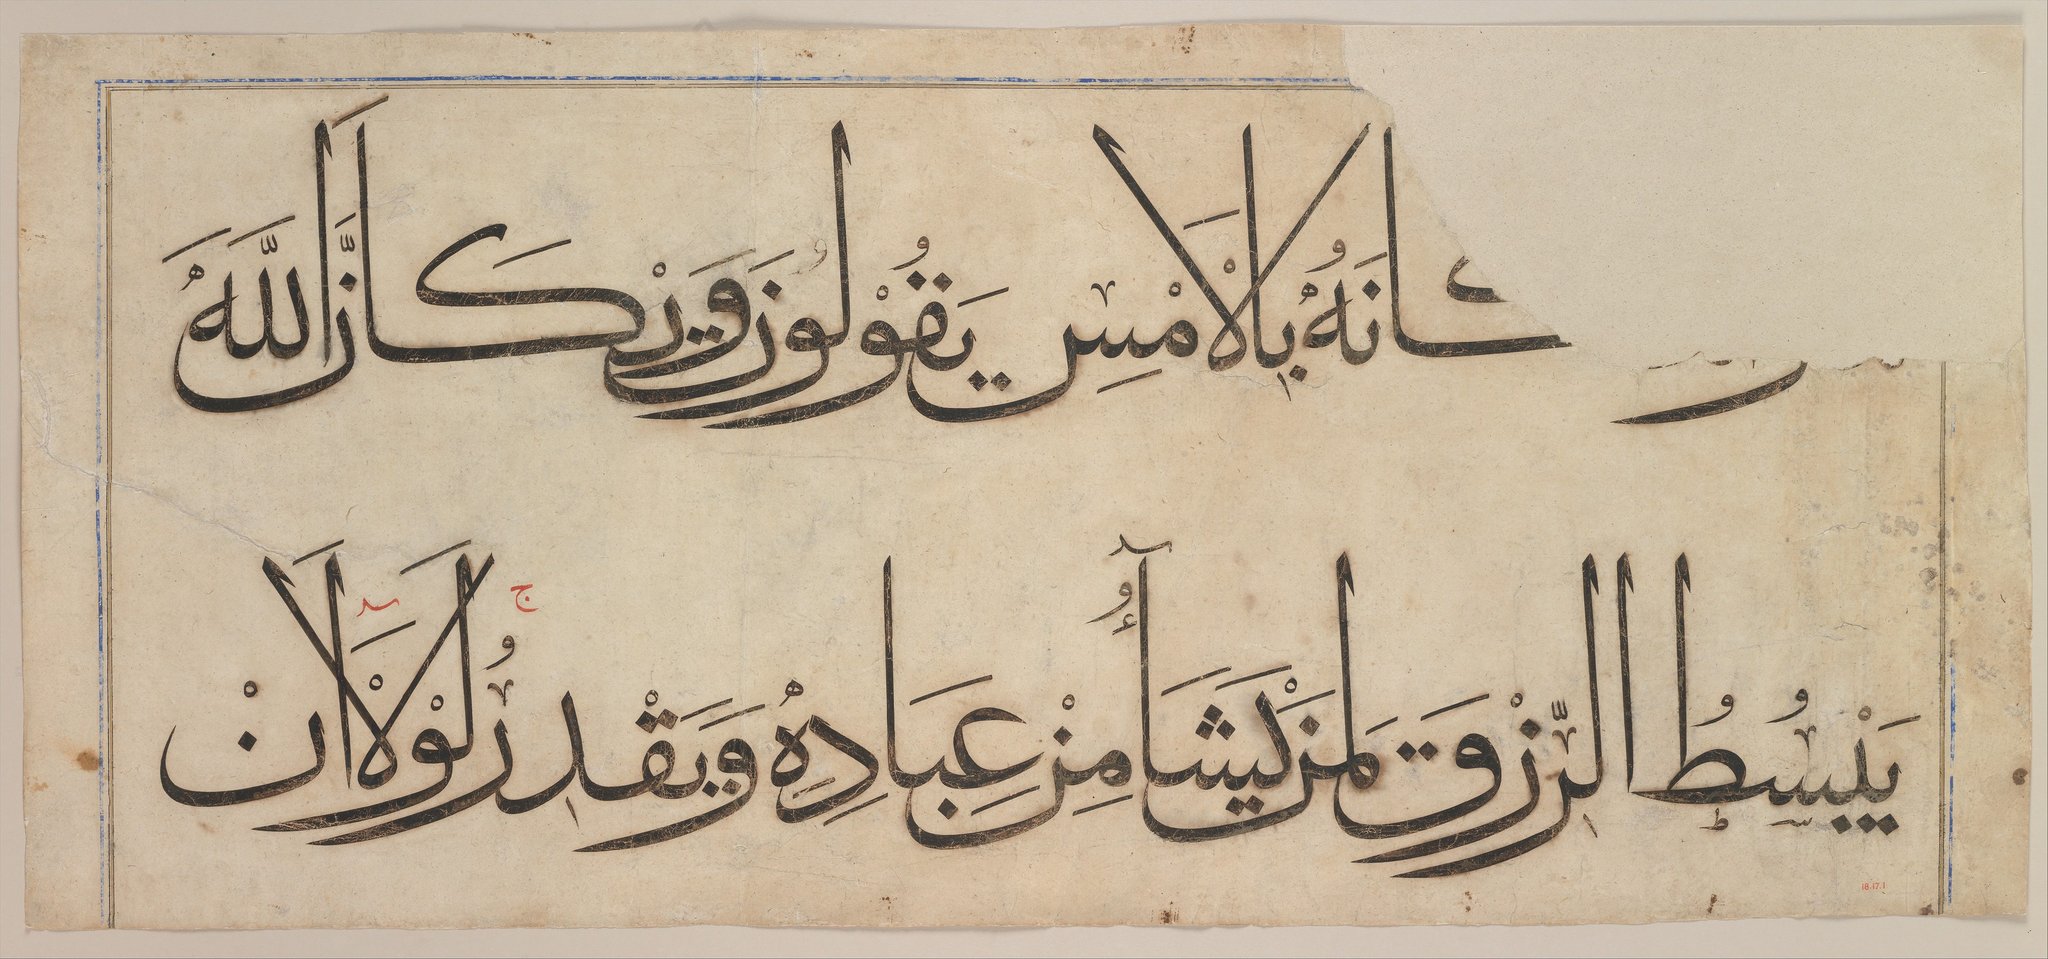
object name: section from a non illustrated manuscript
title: Folio from the "Qur'an of `Umar Aqta'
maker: `umar aqta'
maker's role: calligrapher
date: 1367-1433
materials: gold, ink, paper, watercolor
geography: uzbekistan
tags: qur'an,calligraphy